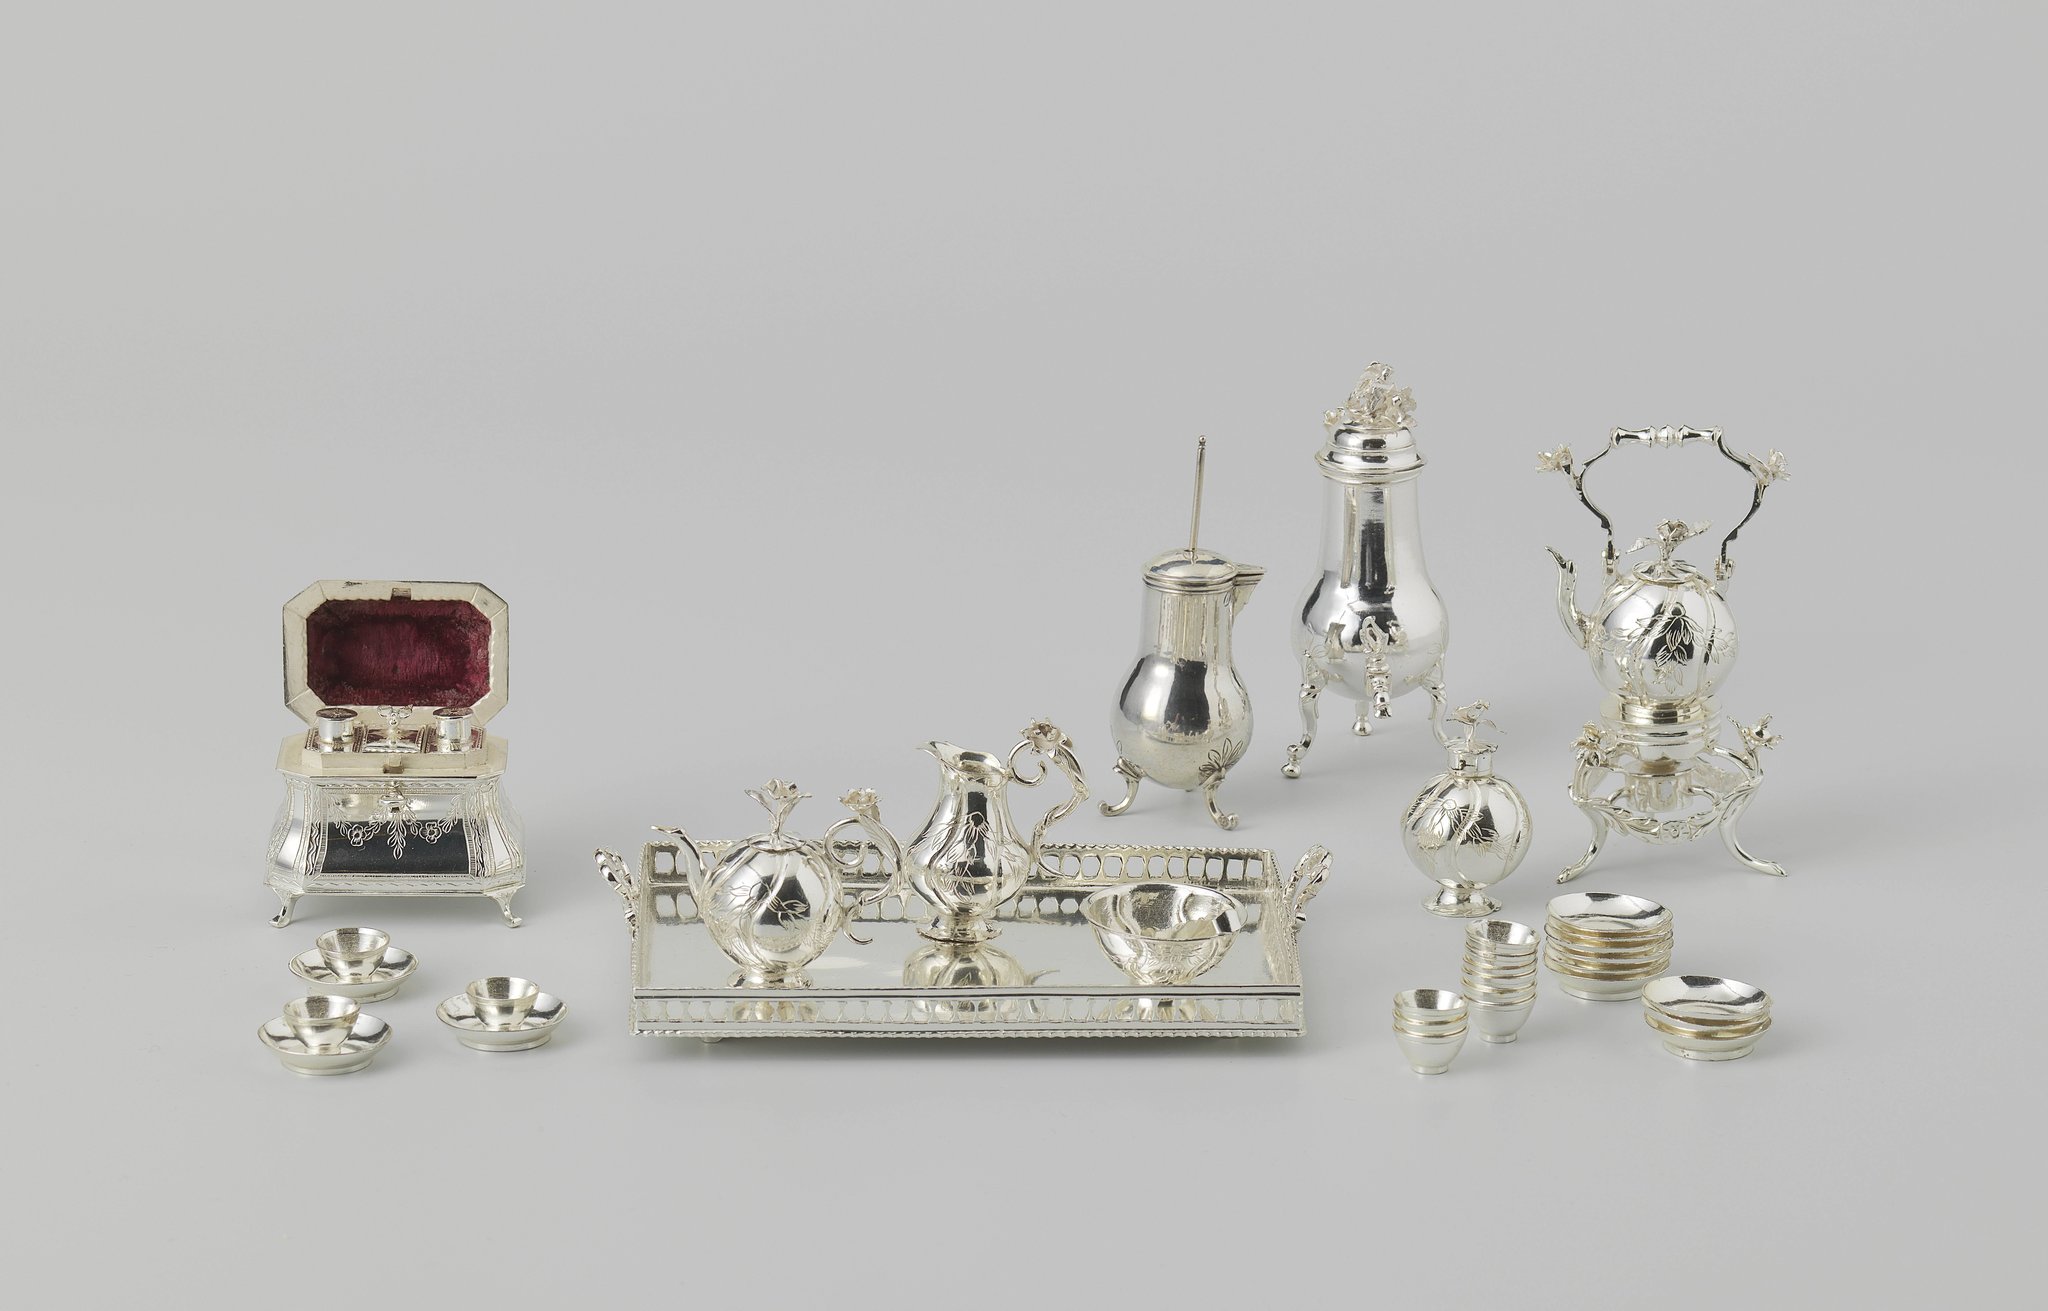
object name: miniature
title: Kop-en-schotel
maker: Anonymous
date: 1775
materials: silver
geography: amsterdam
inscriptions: maker's mark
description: Trechtervormige theekop op een schotel. De schotel heeft een opstaande rand, is onversierd en gemerkt: mt.= Voet 430. De theekop is langs de bovenrand gegraveerd en is niet gemerkt. De kop en schotel worden bewaard als onderdeel van een theeservies (BK-NM-11177-142). Het theeservies heeft in het totaal twaalf kop en schotels die gelijk zijn aan dit exemplaar.